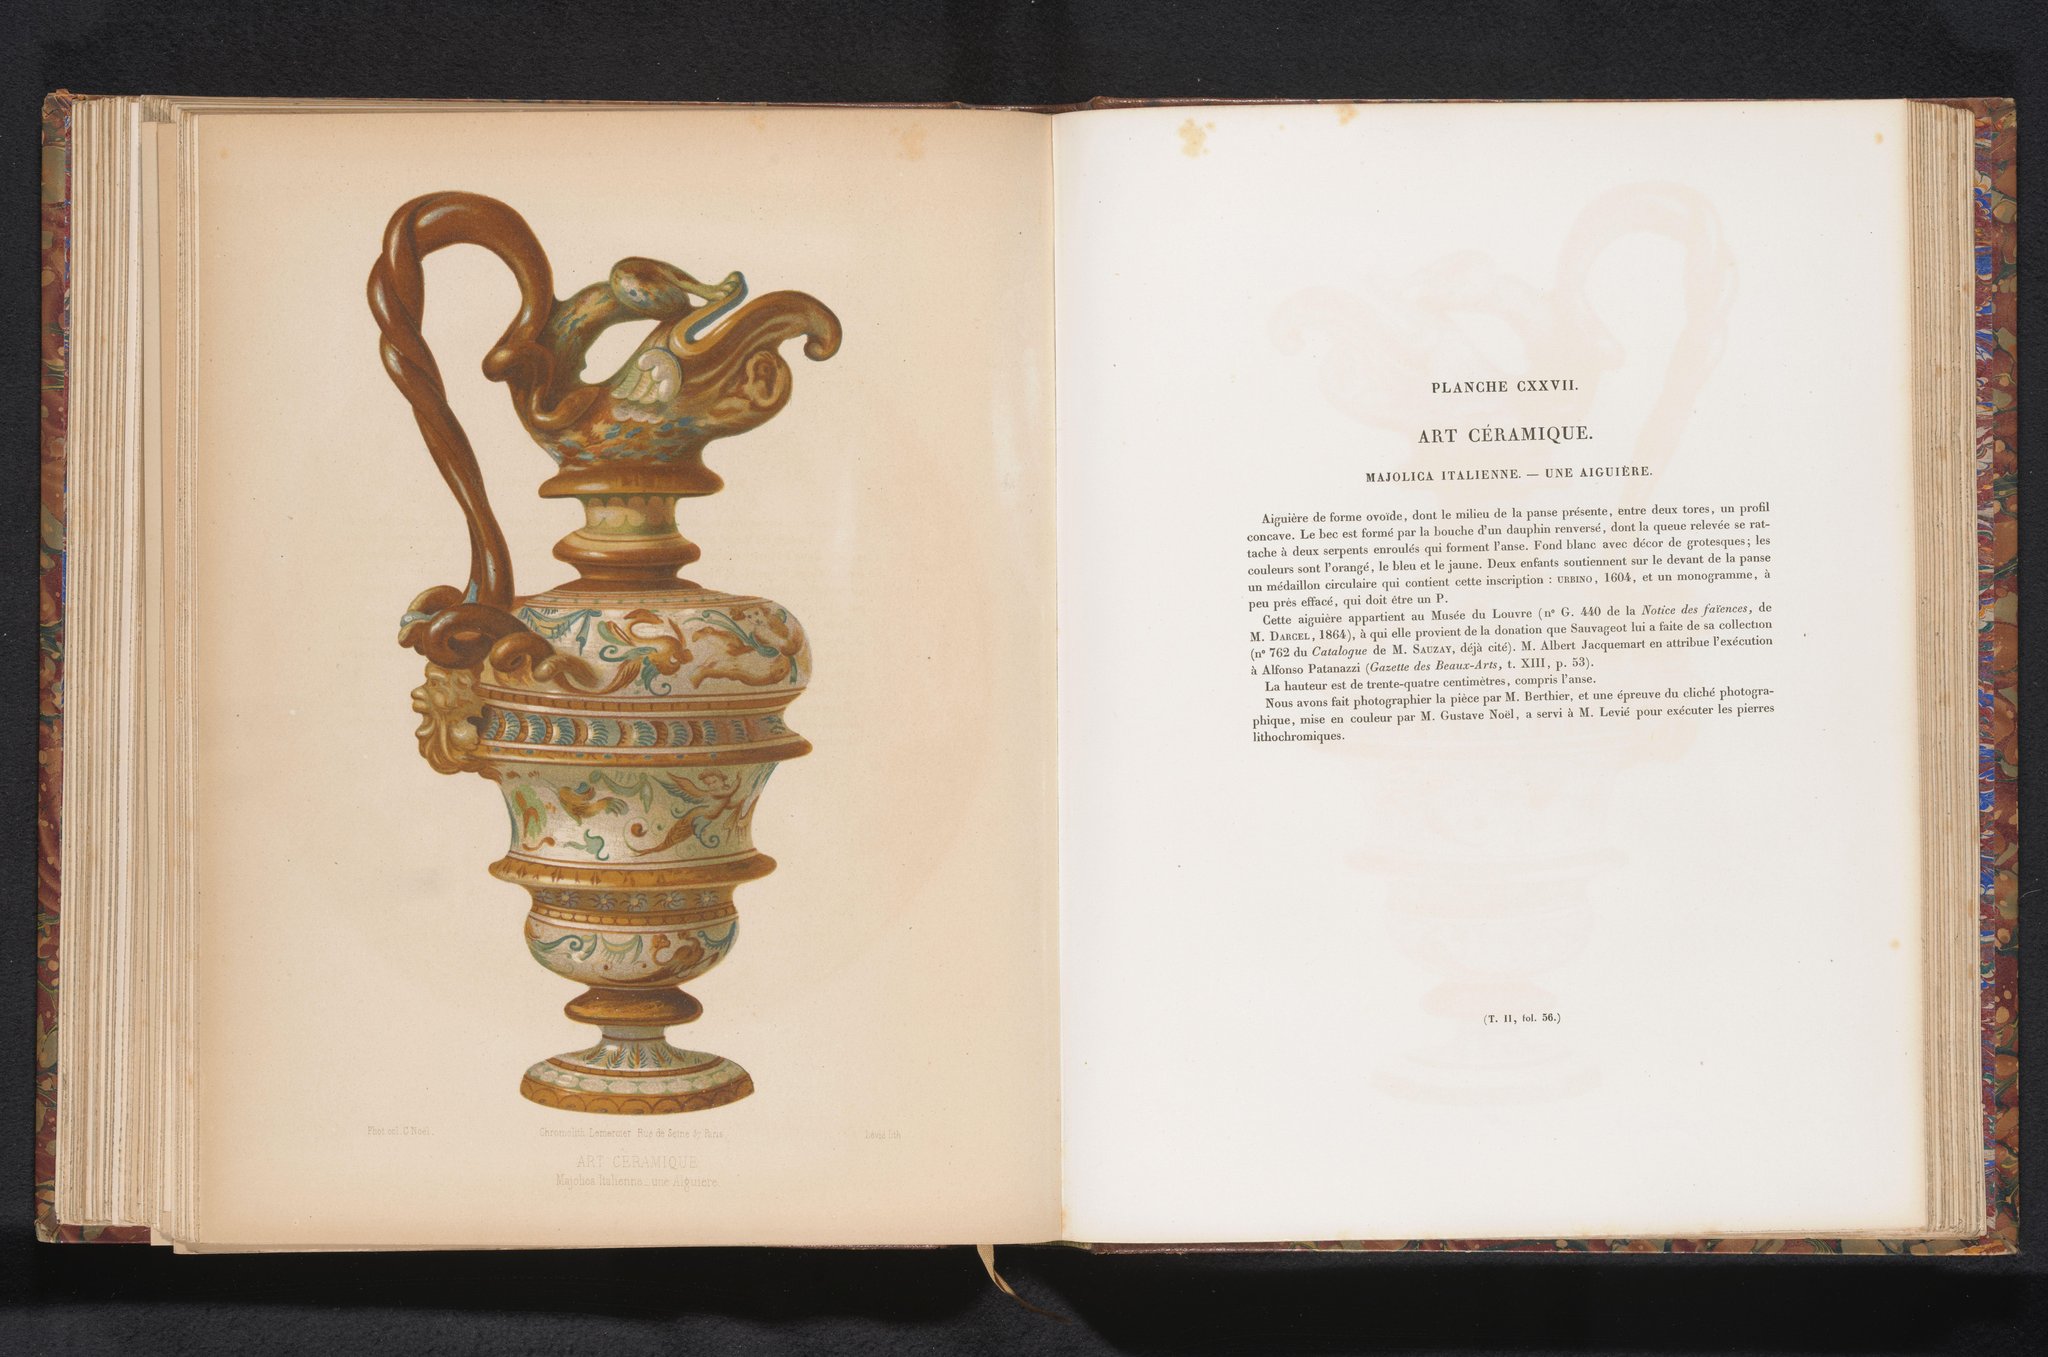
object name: reproduction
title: Majolica Italienne, un Aiguière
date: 1859-1864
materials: paper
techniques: chromolithography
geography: paris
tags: container of ceramics: jar, jug, pot, vase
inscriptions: name: ‘Phot. col. C. Noël./ Levié lith’